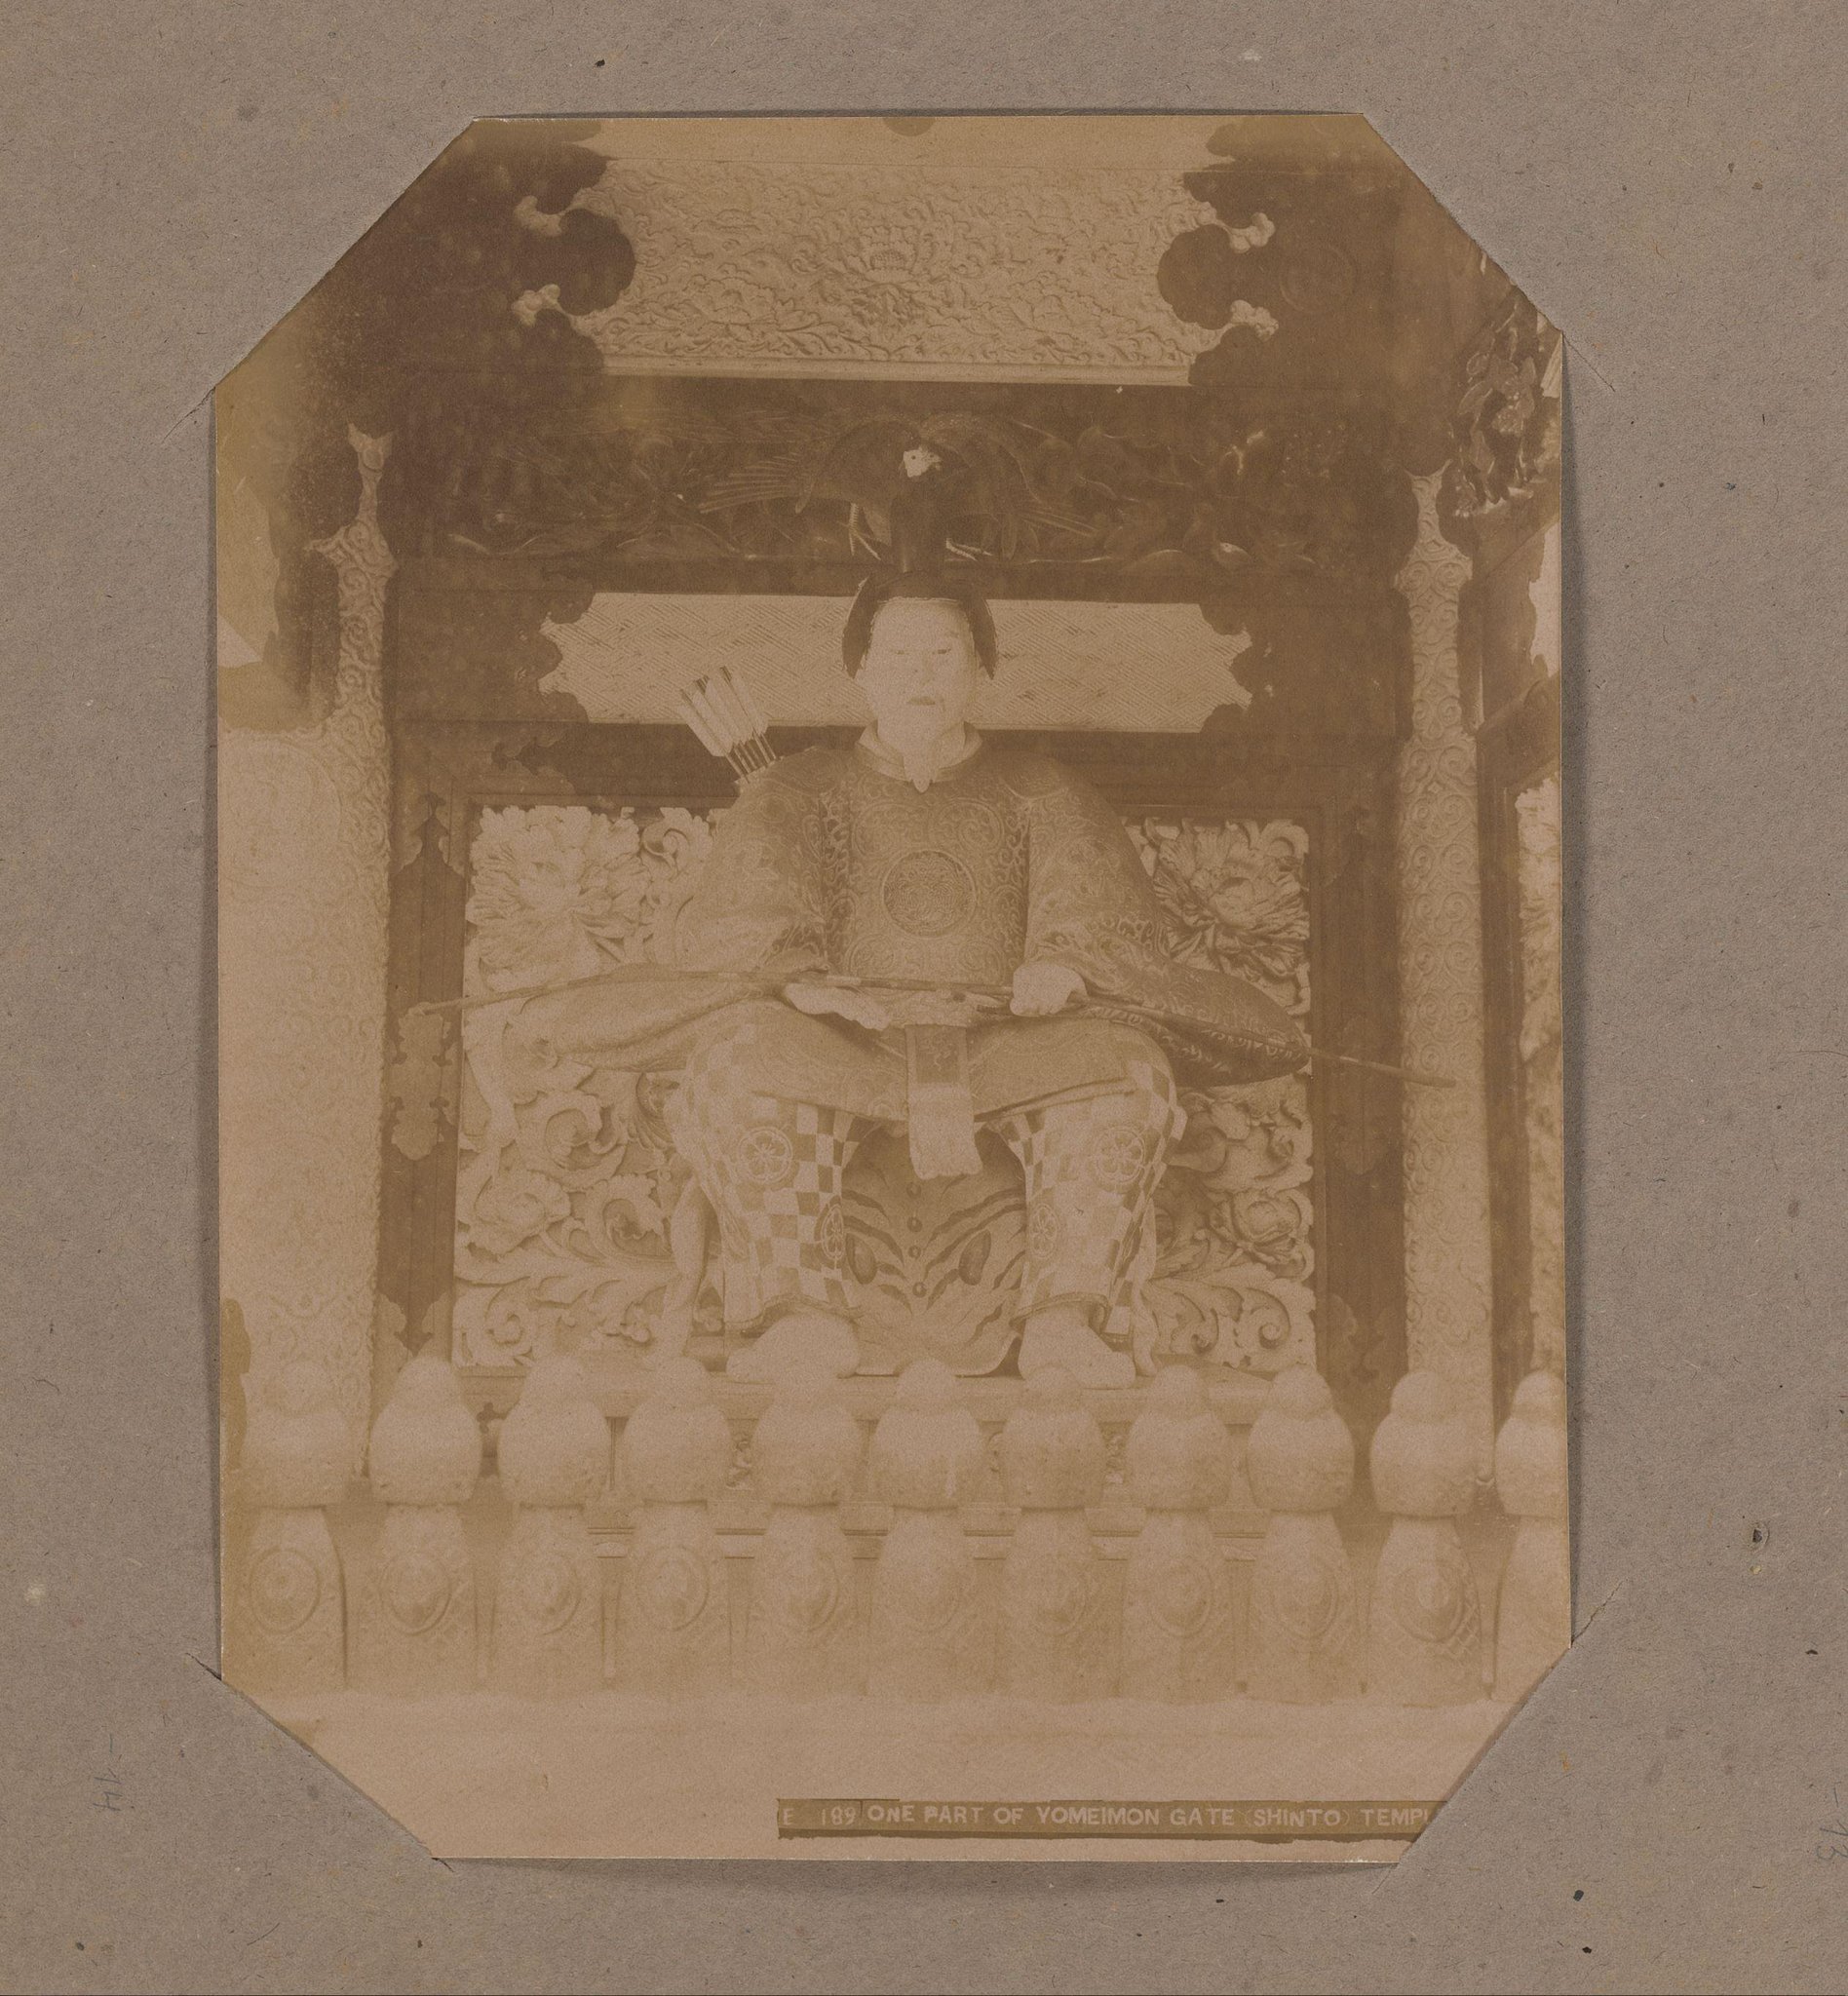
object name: album leaf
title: Deel van de Yomeinon poort van het Tosho-gu heiligdom in Nikko, Japan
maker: Anonymous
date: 1890-1903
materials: paper, photographic support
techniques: albumen print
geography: nikko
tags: temple, shrine ~ shinto, gate, entrance, piece of sculpture, reproduction of a piece of sculpture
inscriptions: inscription: ‘E 189 One Part of Yomeinon Gate (Shinto) Temple Nikko’